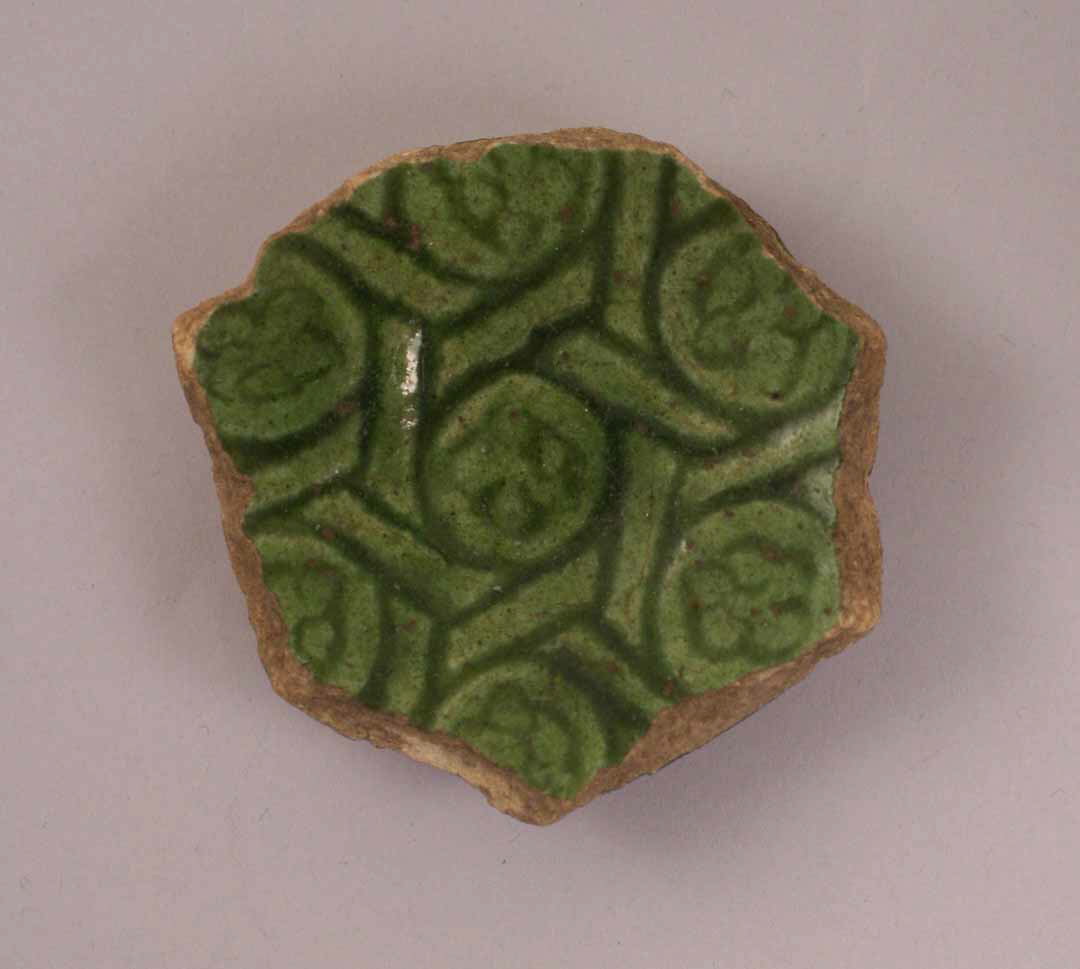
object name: ceramic fragment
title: Fragment of a Dish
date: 1201-1400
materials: earthenware, glaze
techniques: incising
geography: egypt